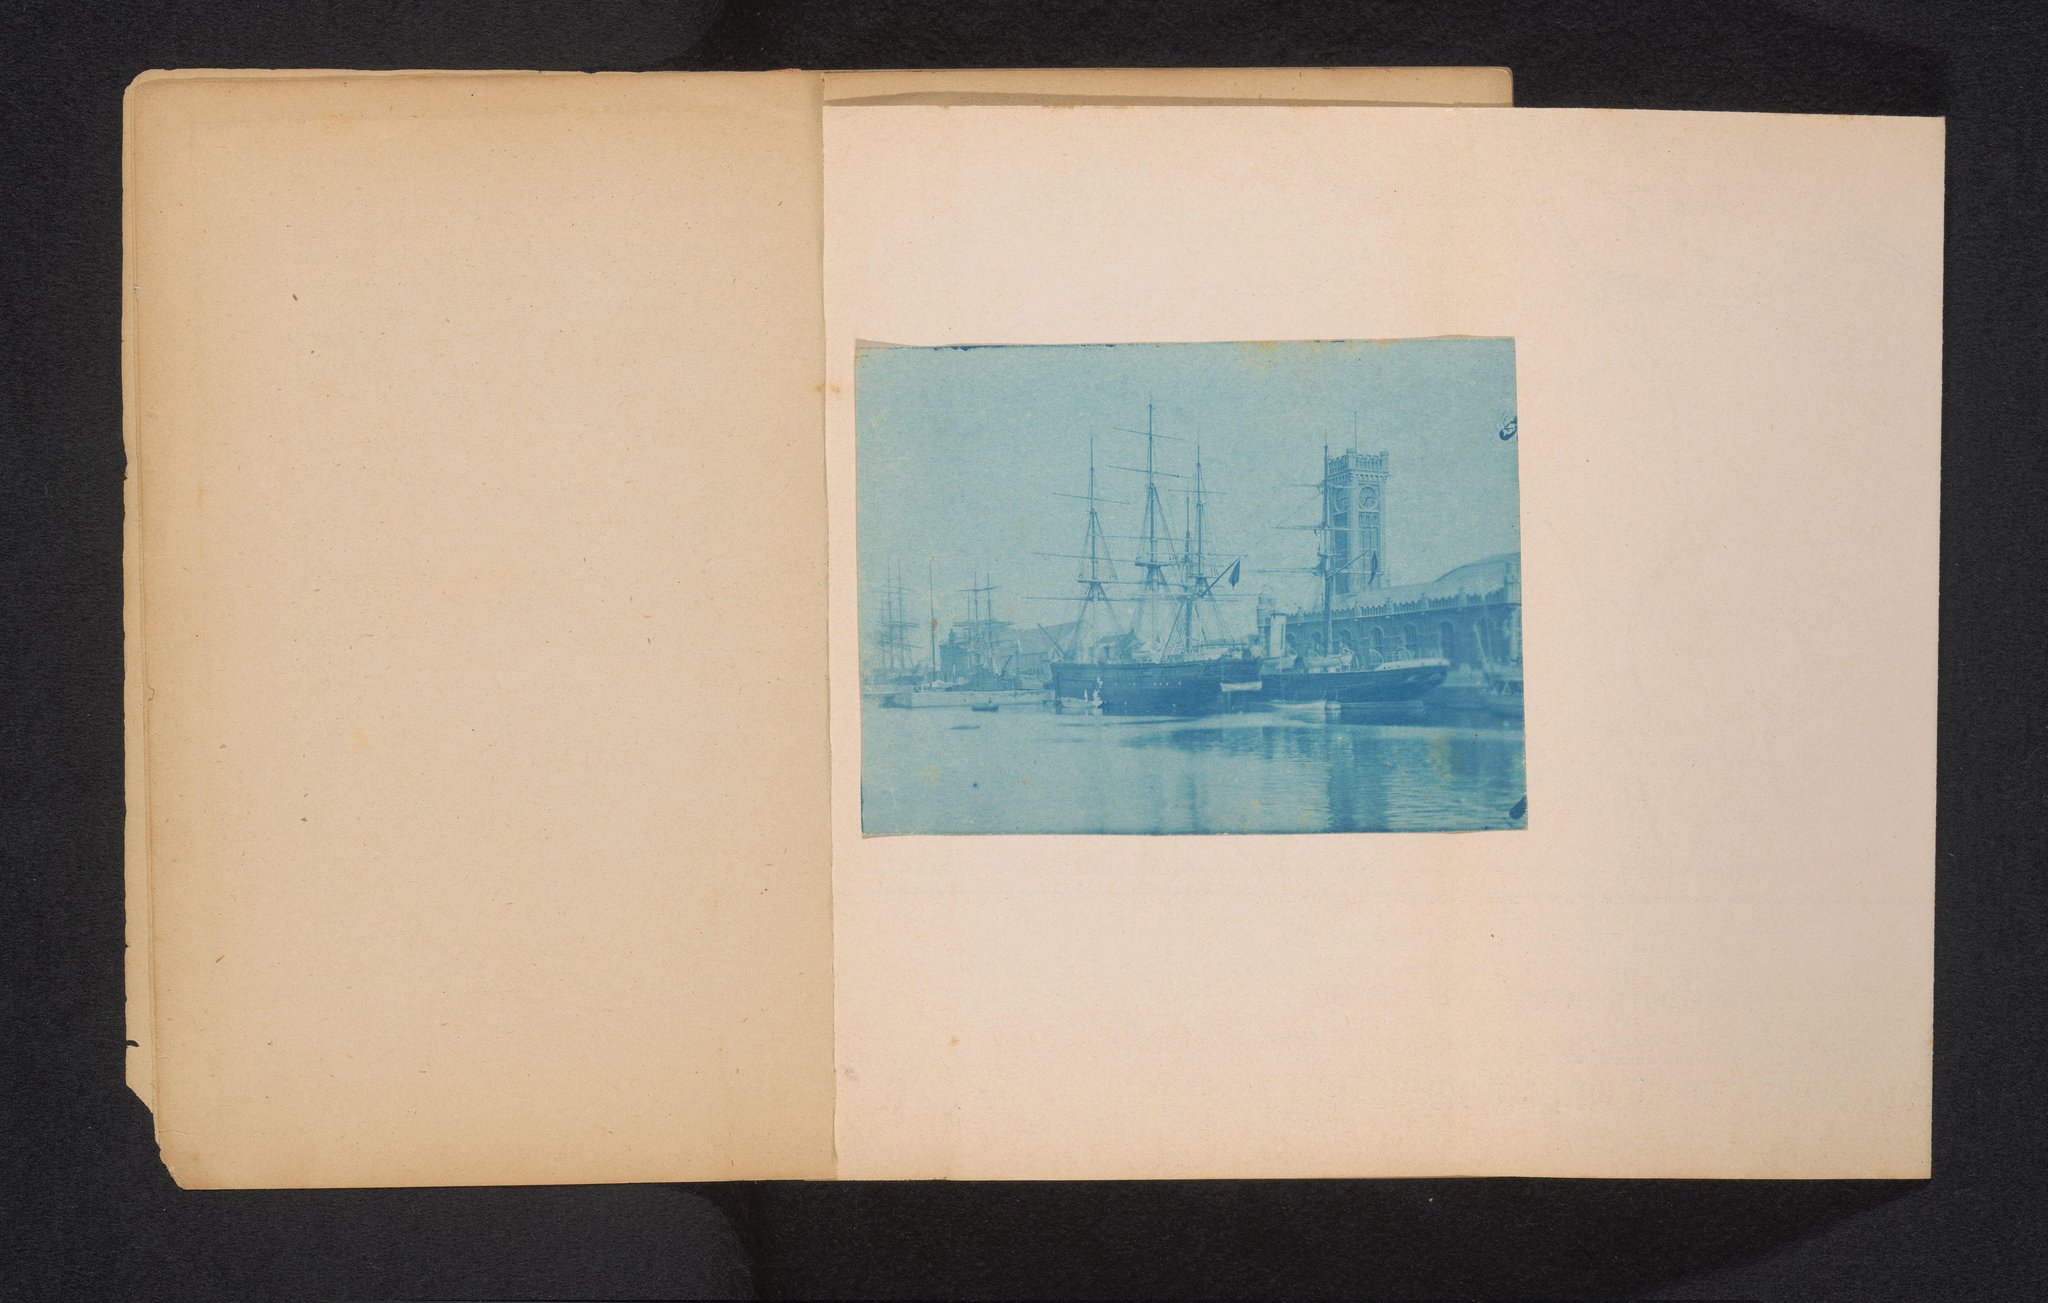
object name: page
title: Gezicht op Hoei en de Maas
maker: Anonymous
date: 1885-1890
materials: photographic support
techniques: cyanotype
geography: hoei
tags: sailing-ship, sailing-boat, city-view in general; 'veduta', river